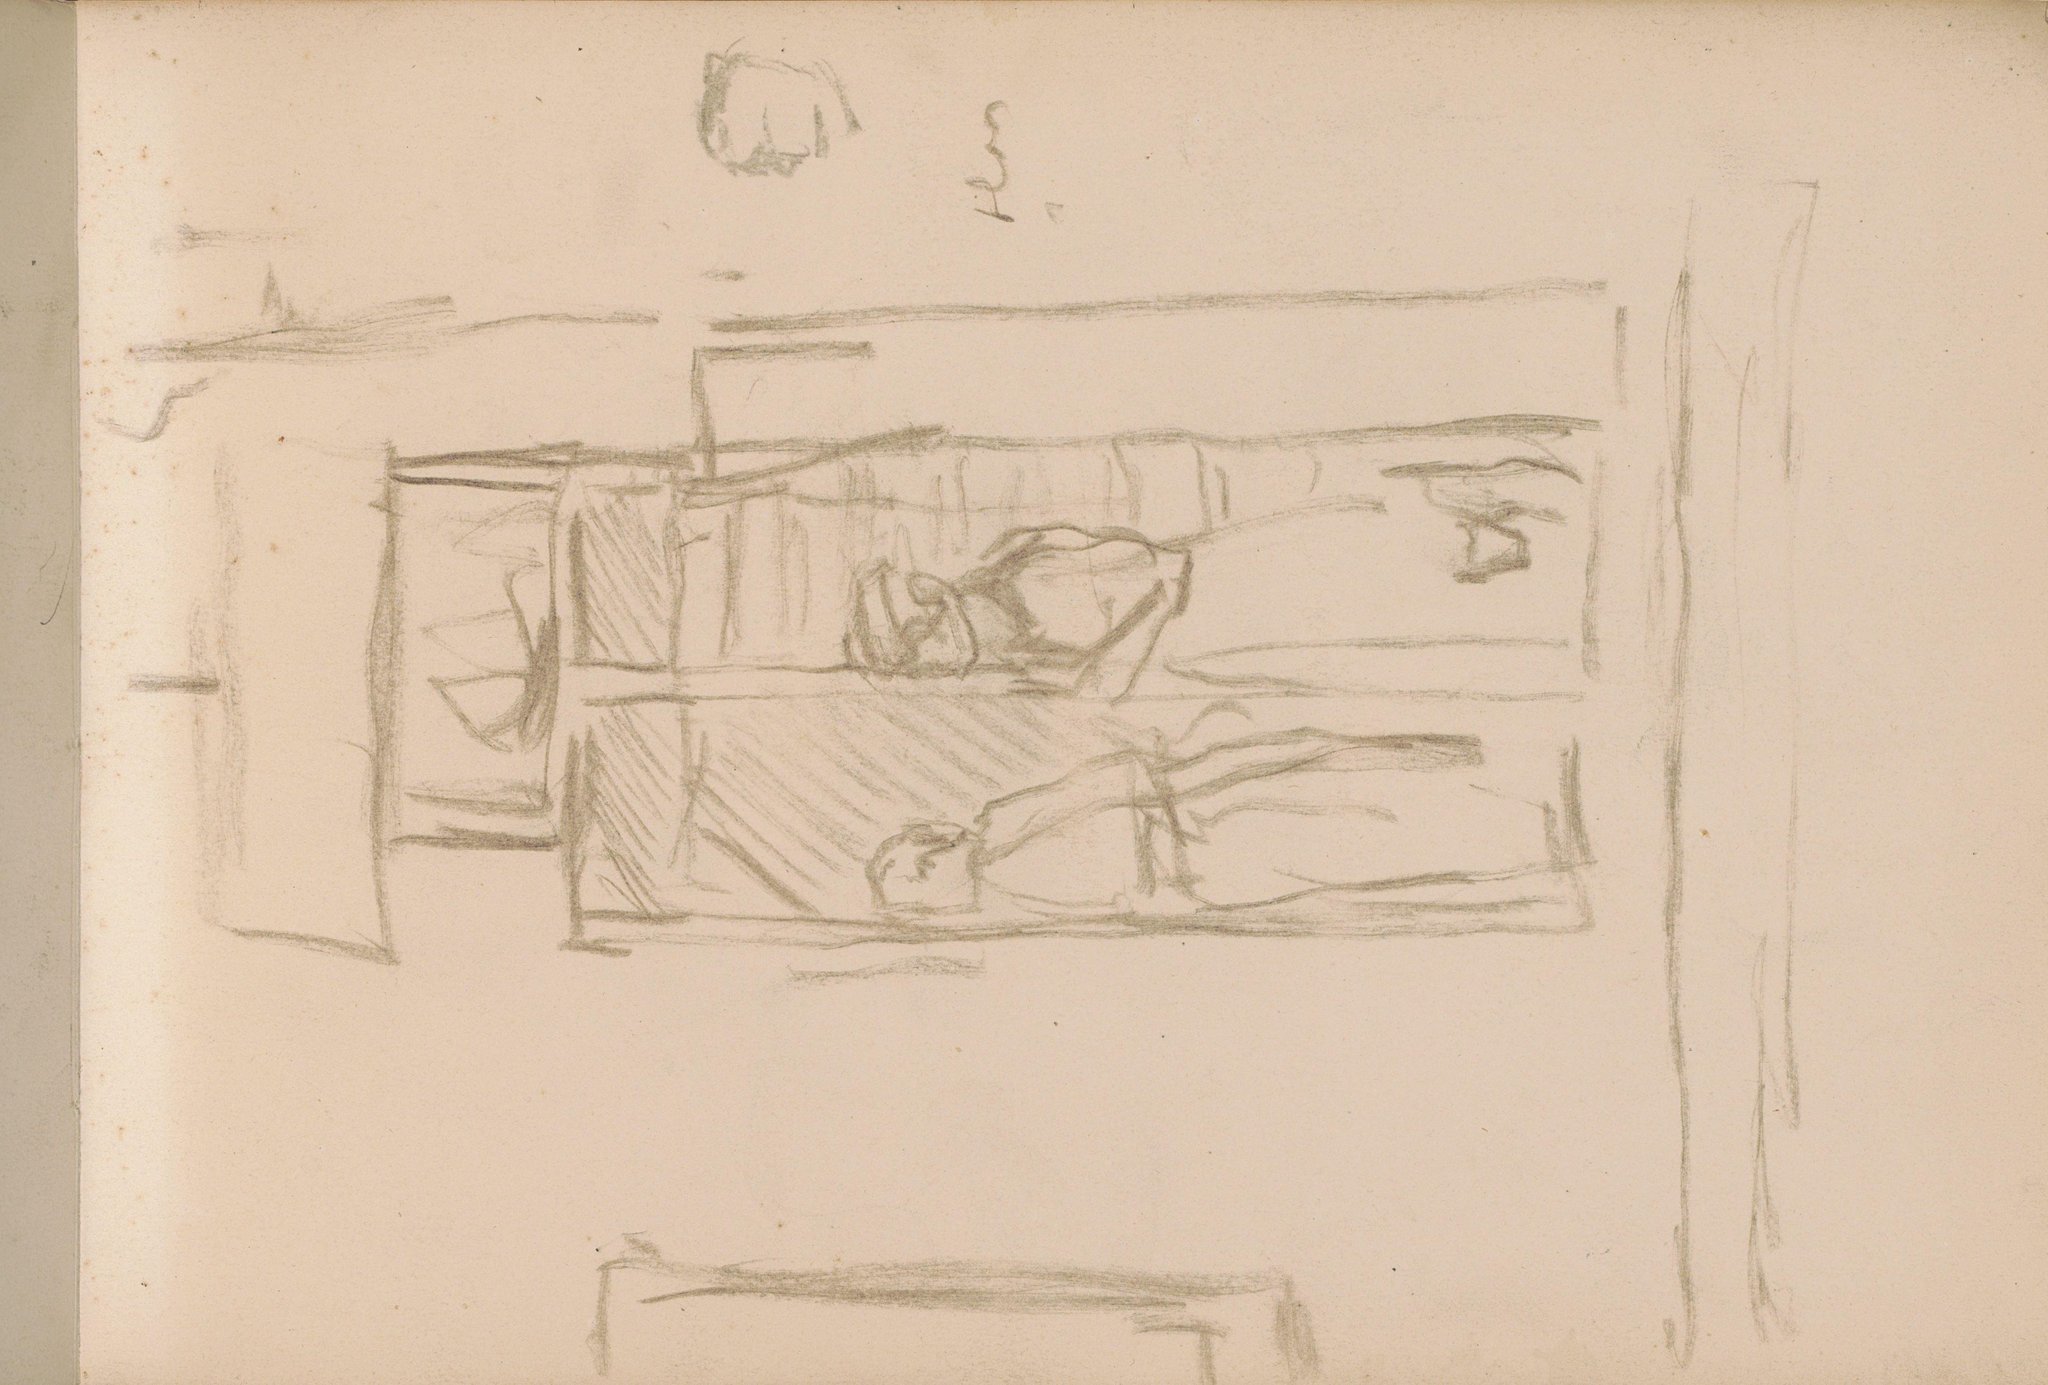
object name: sketchbook leaf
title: Twee vrouwen in de deuropening van Nieuwe Teertuinen 33 te Amsterdam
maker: george hendrik breitner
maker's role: draughtsman, painter, print maker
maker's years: 1857-1923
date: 1898-1914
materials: chalk, paper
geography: amsterdam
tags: urban housing, stone tablet in façade, open door, adult woman (+ two persons)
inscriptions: kleurnotitie, handgeschreven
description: Boven de deur de gevelsteen 'Roode Galy'. Pagina 28 uit een schetsboek met 21 bladen.